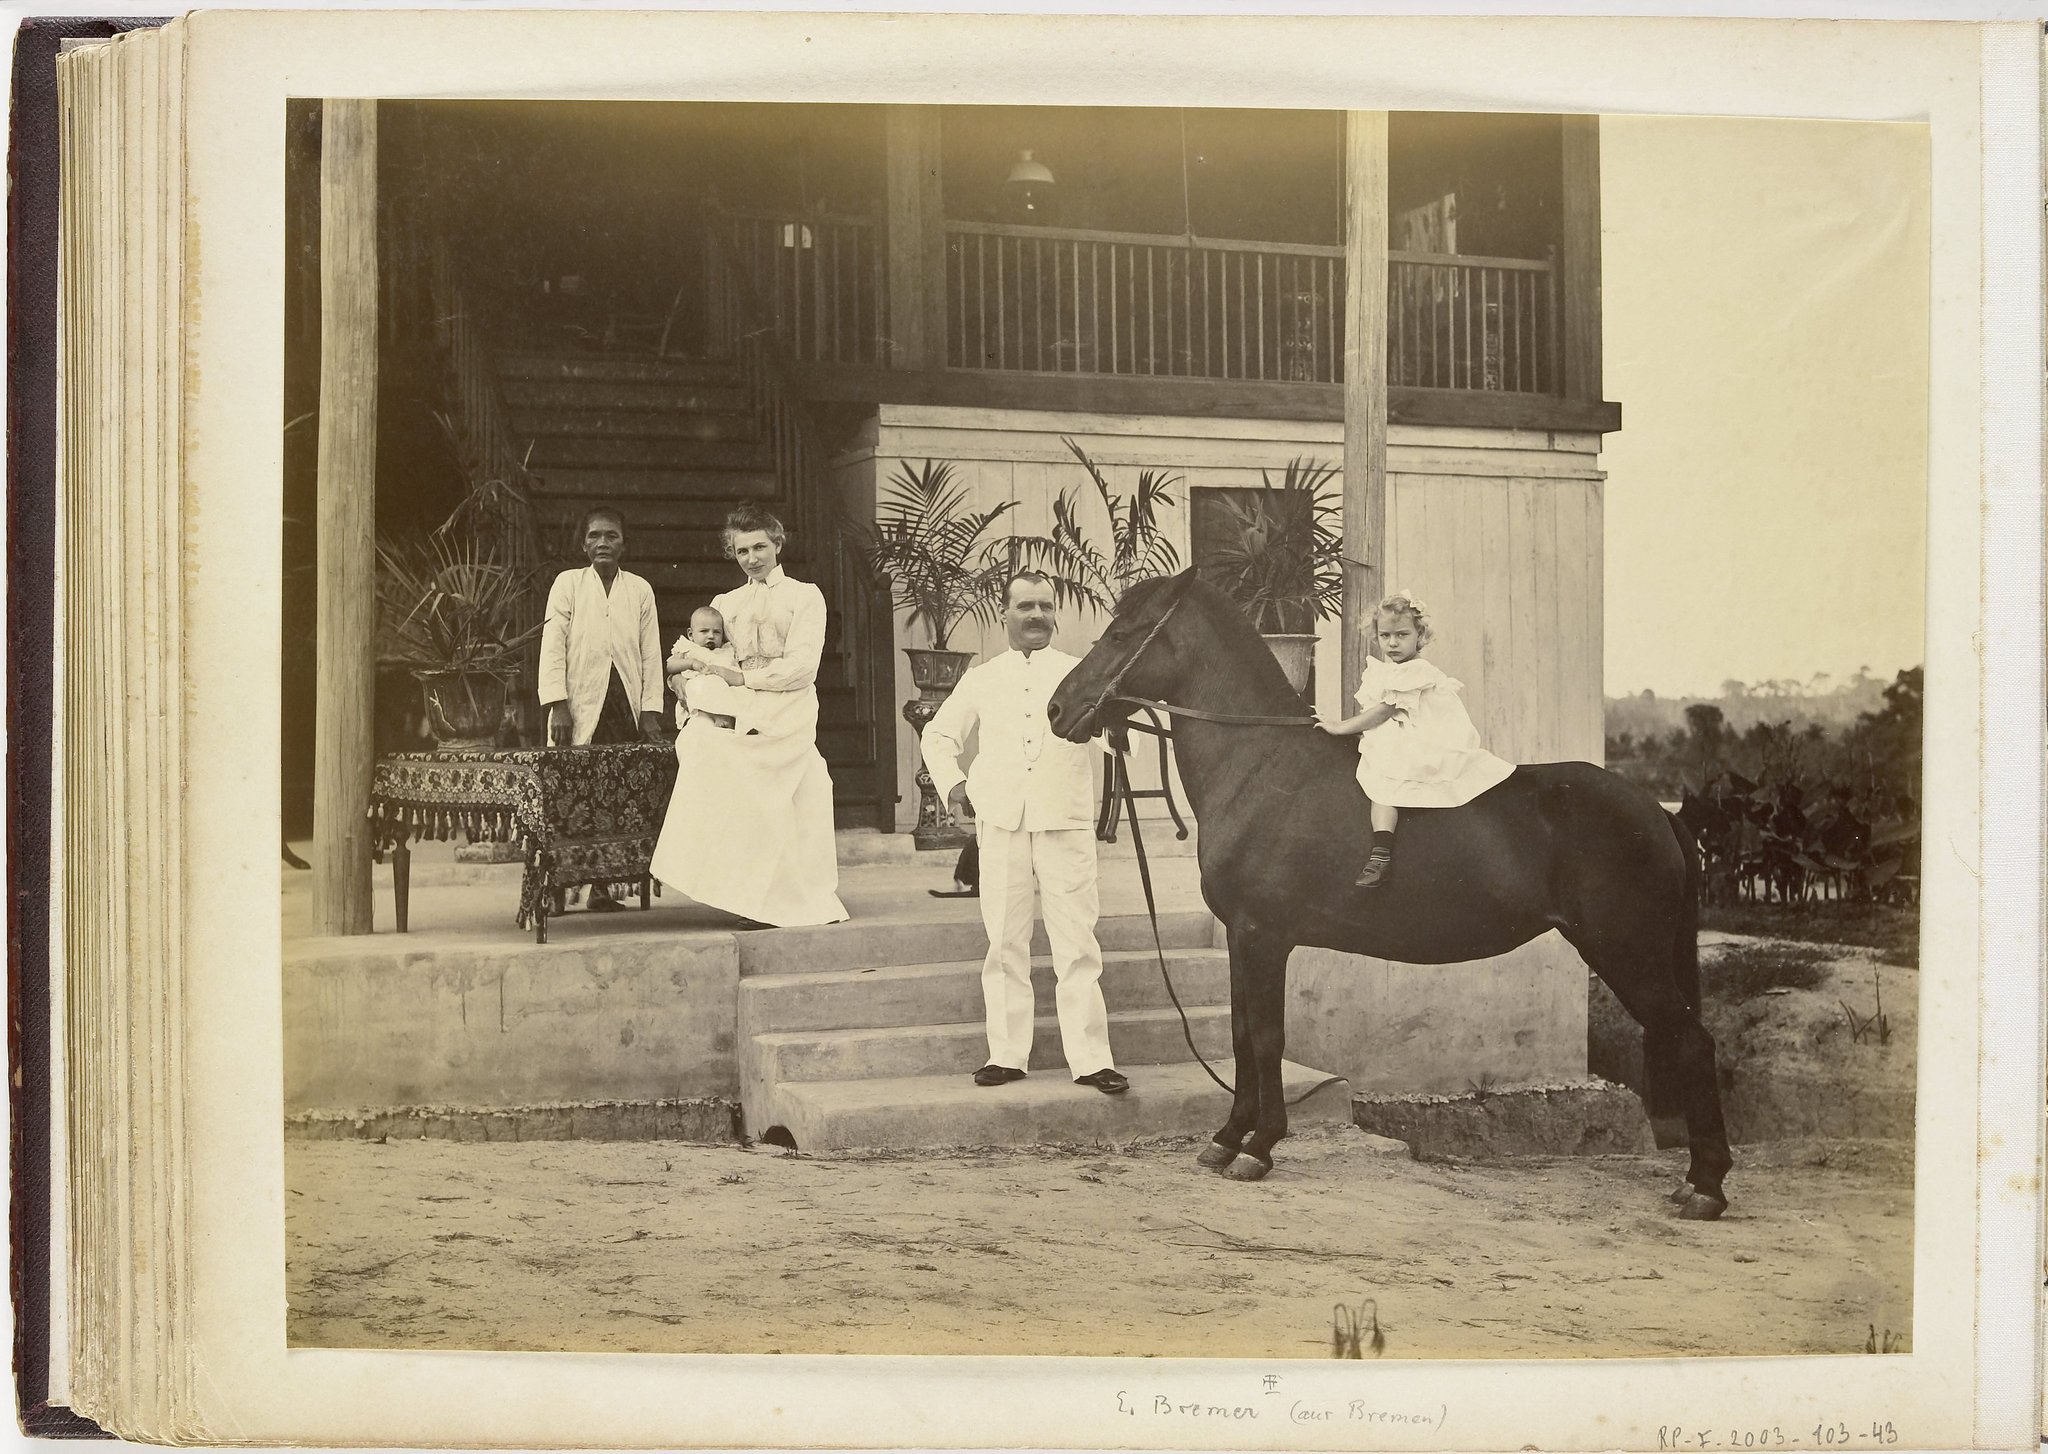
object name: photograph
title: Portret van E. Bremer met vrouw, kinderen, bediende en paard voor zijn huis, Langkat Sumatra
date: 1890-1900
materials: cardboard, paper, photographic support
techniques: albumen print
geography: bindjai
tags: sumatra